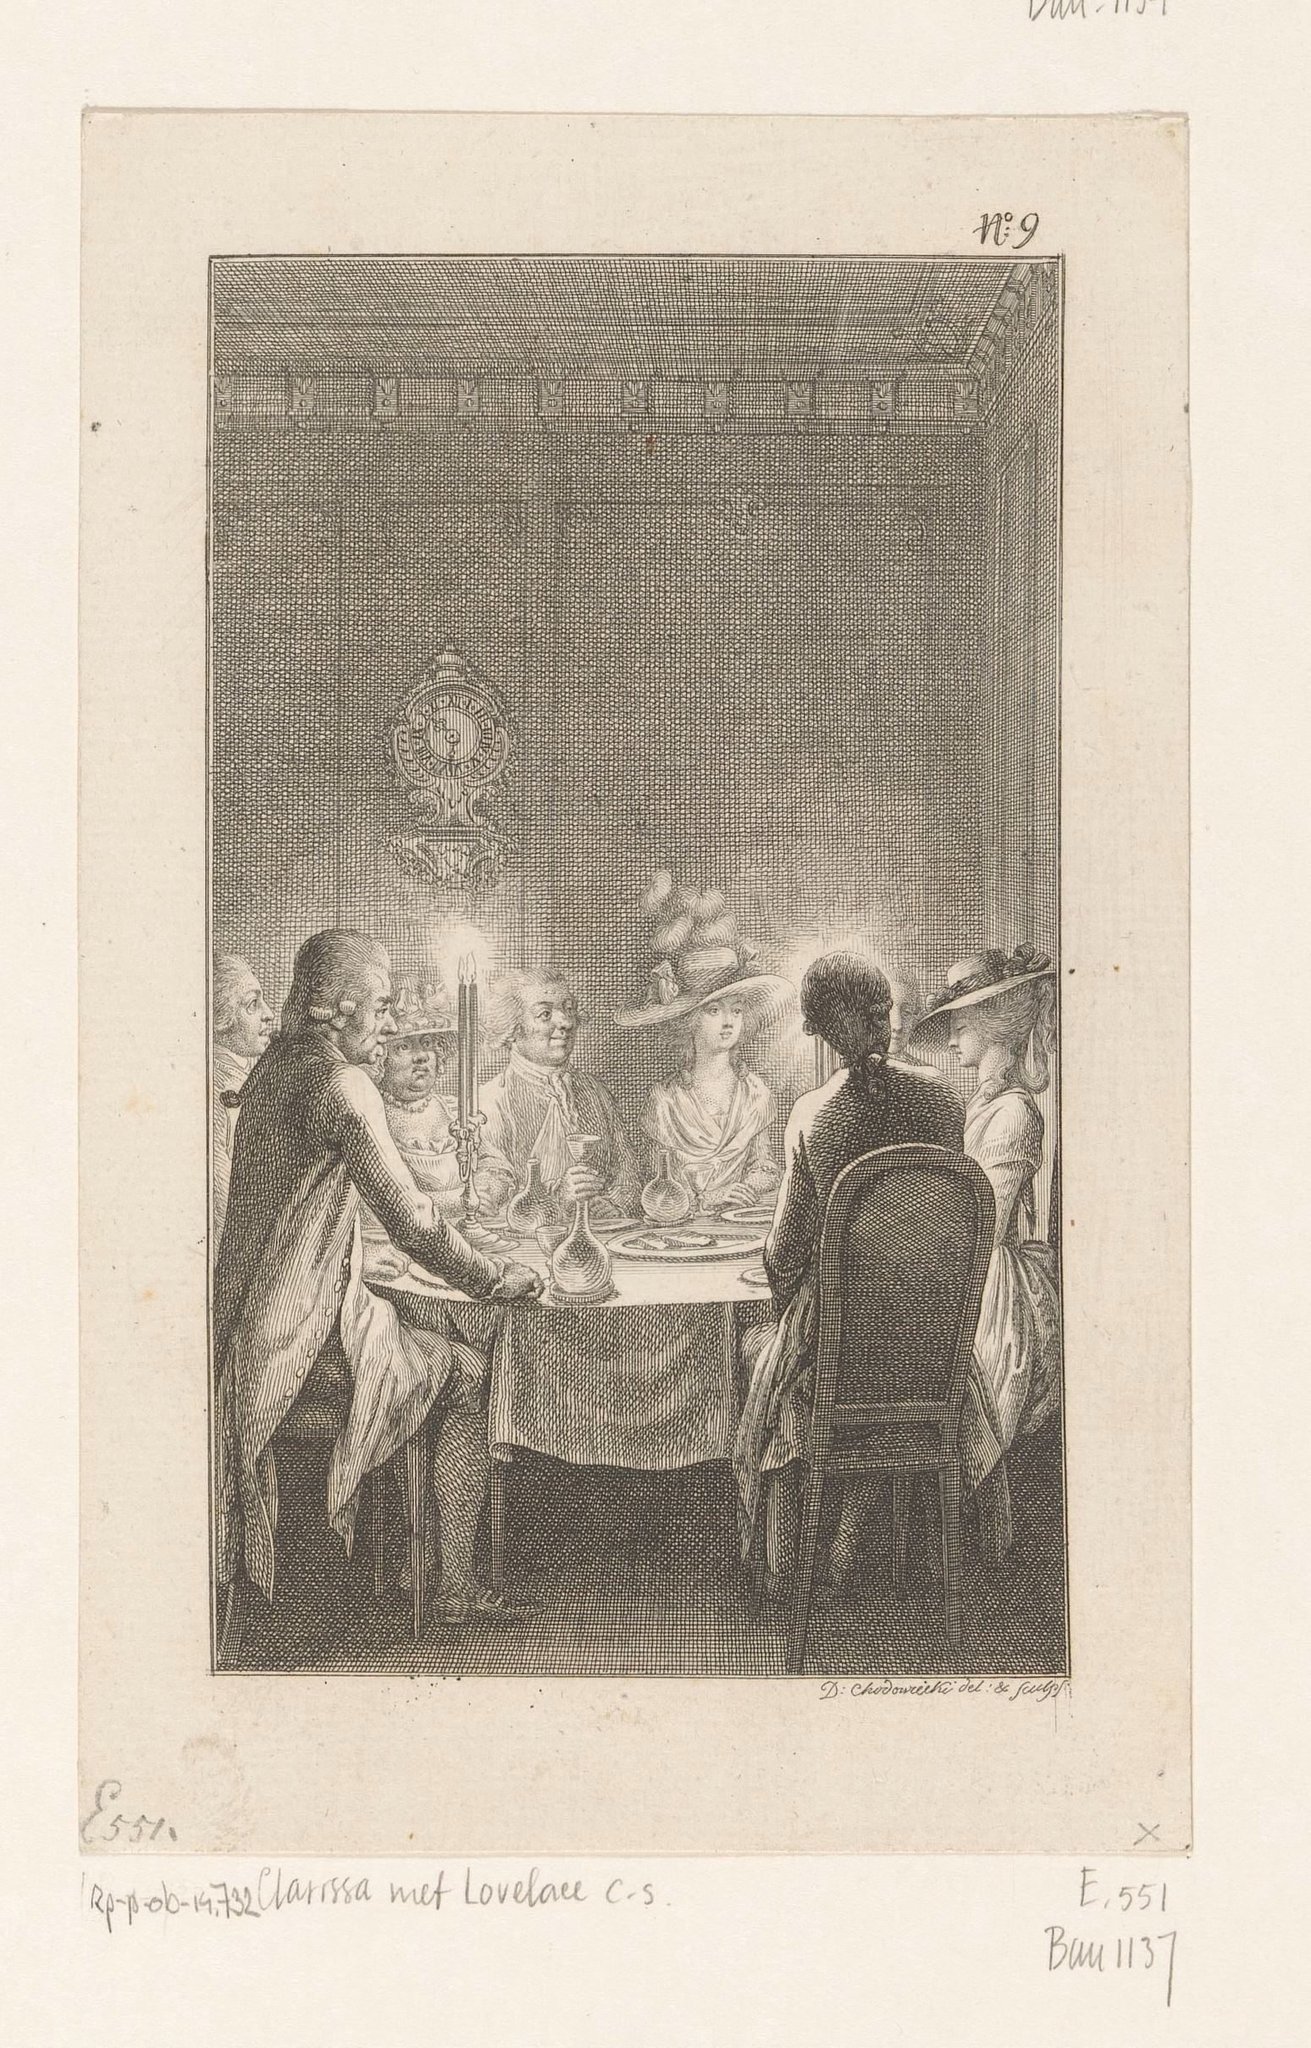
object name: print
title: Clarissa aan tafel bij Lovelace en zijn vrienden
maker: daniel nikolaus chodowiecki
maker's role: draughtsman, print maker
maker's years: 1726-1801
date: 1784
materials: paper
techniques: etching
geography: berlin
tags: literature, candle, evening meal, dinner, supper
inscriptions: collector's mark: Lugt 2228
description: Prent gebruikt voor: Richardson, Samuel. Clarisse Harlowe, Traduction nouvelle et seule complete par (...). 14 dln. Genève en Parijs: Barde, 1785-87.